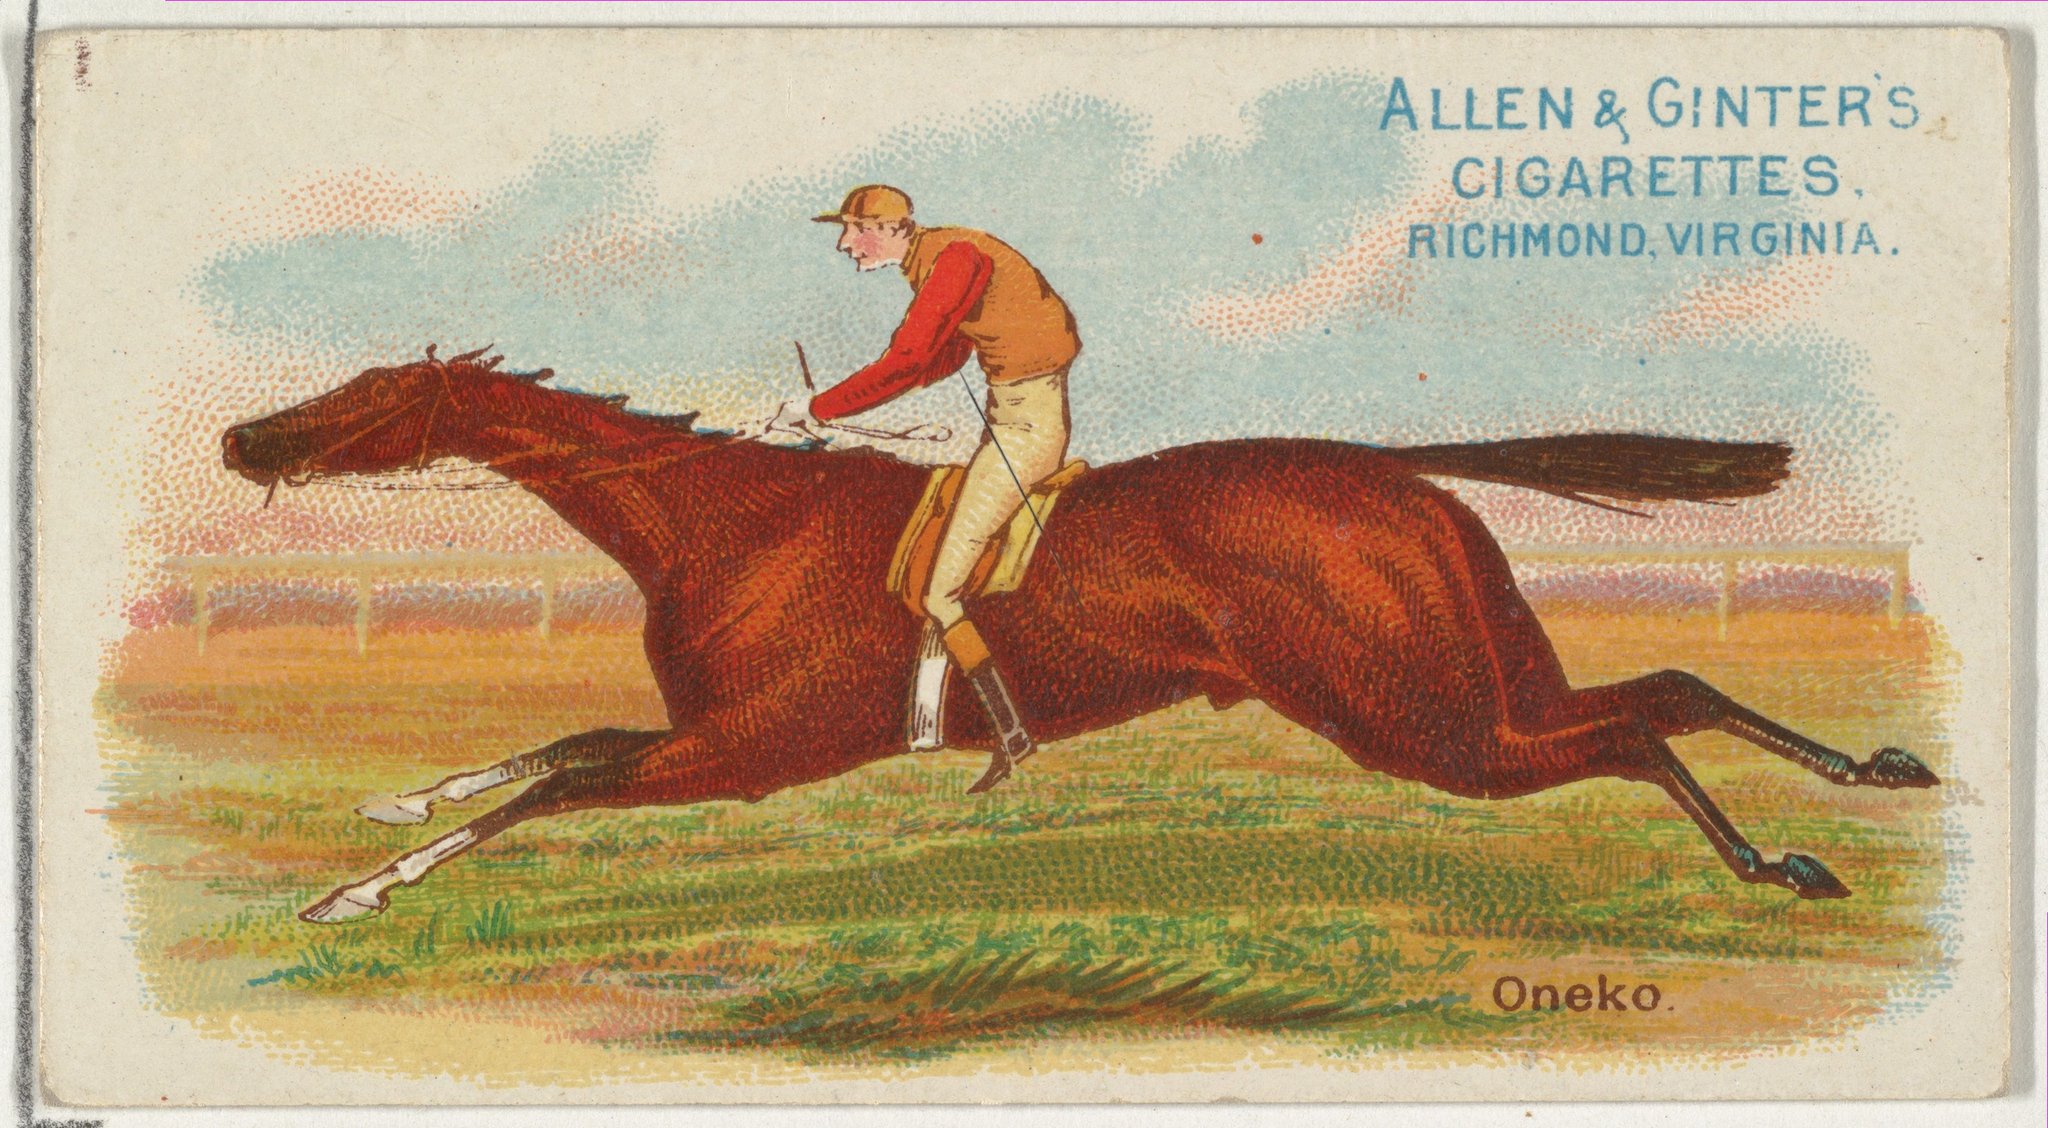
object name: print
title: Oneko, from The World's Racers series (N32) for Allen & Ginter Cigarettes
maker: allen & ginter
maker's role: publisher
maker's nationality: american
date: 1888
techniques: color lithograph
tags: men,horses,jockeys